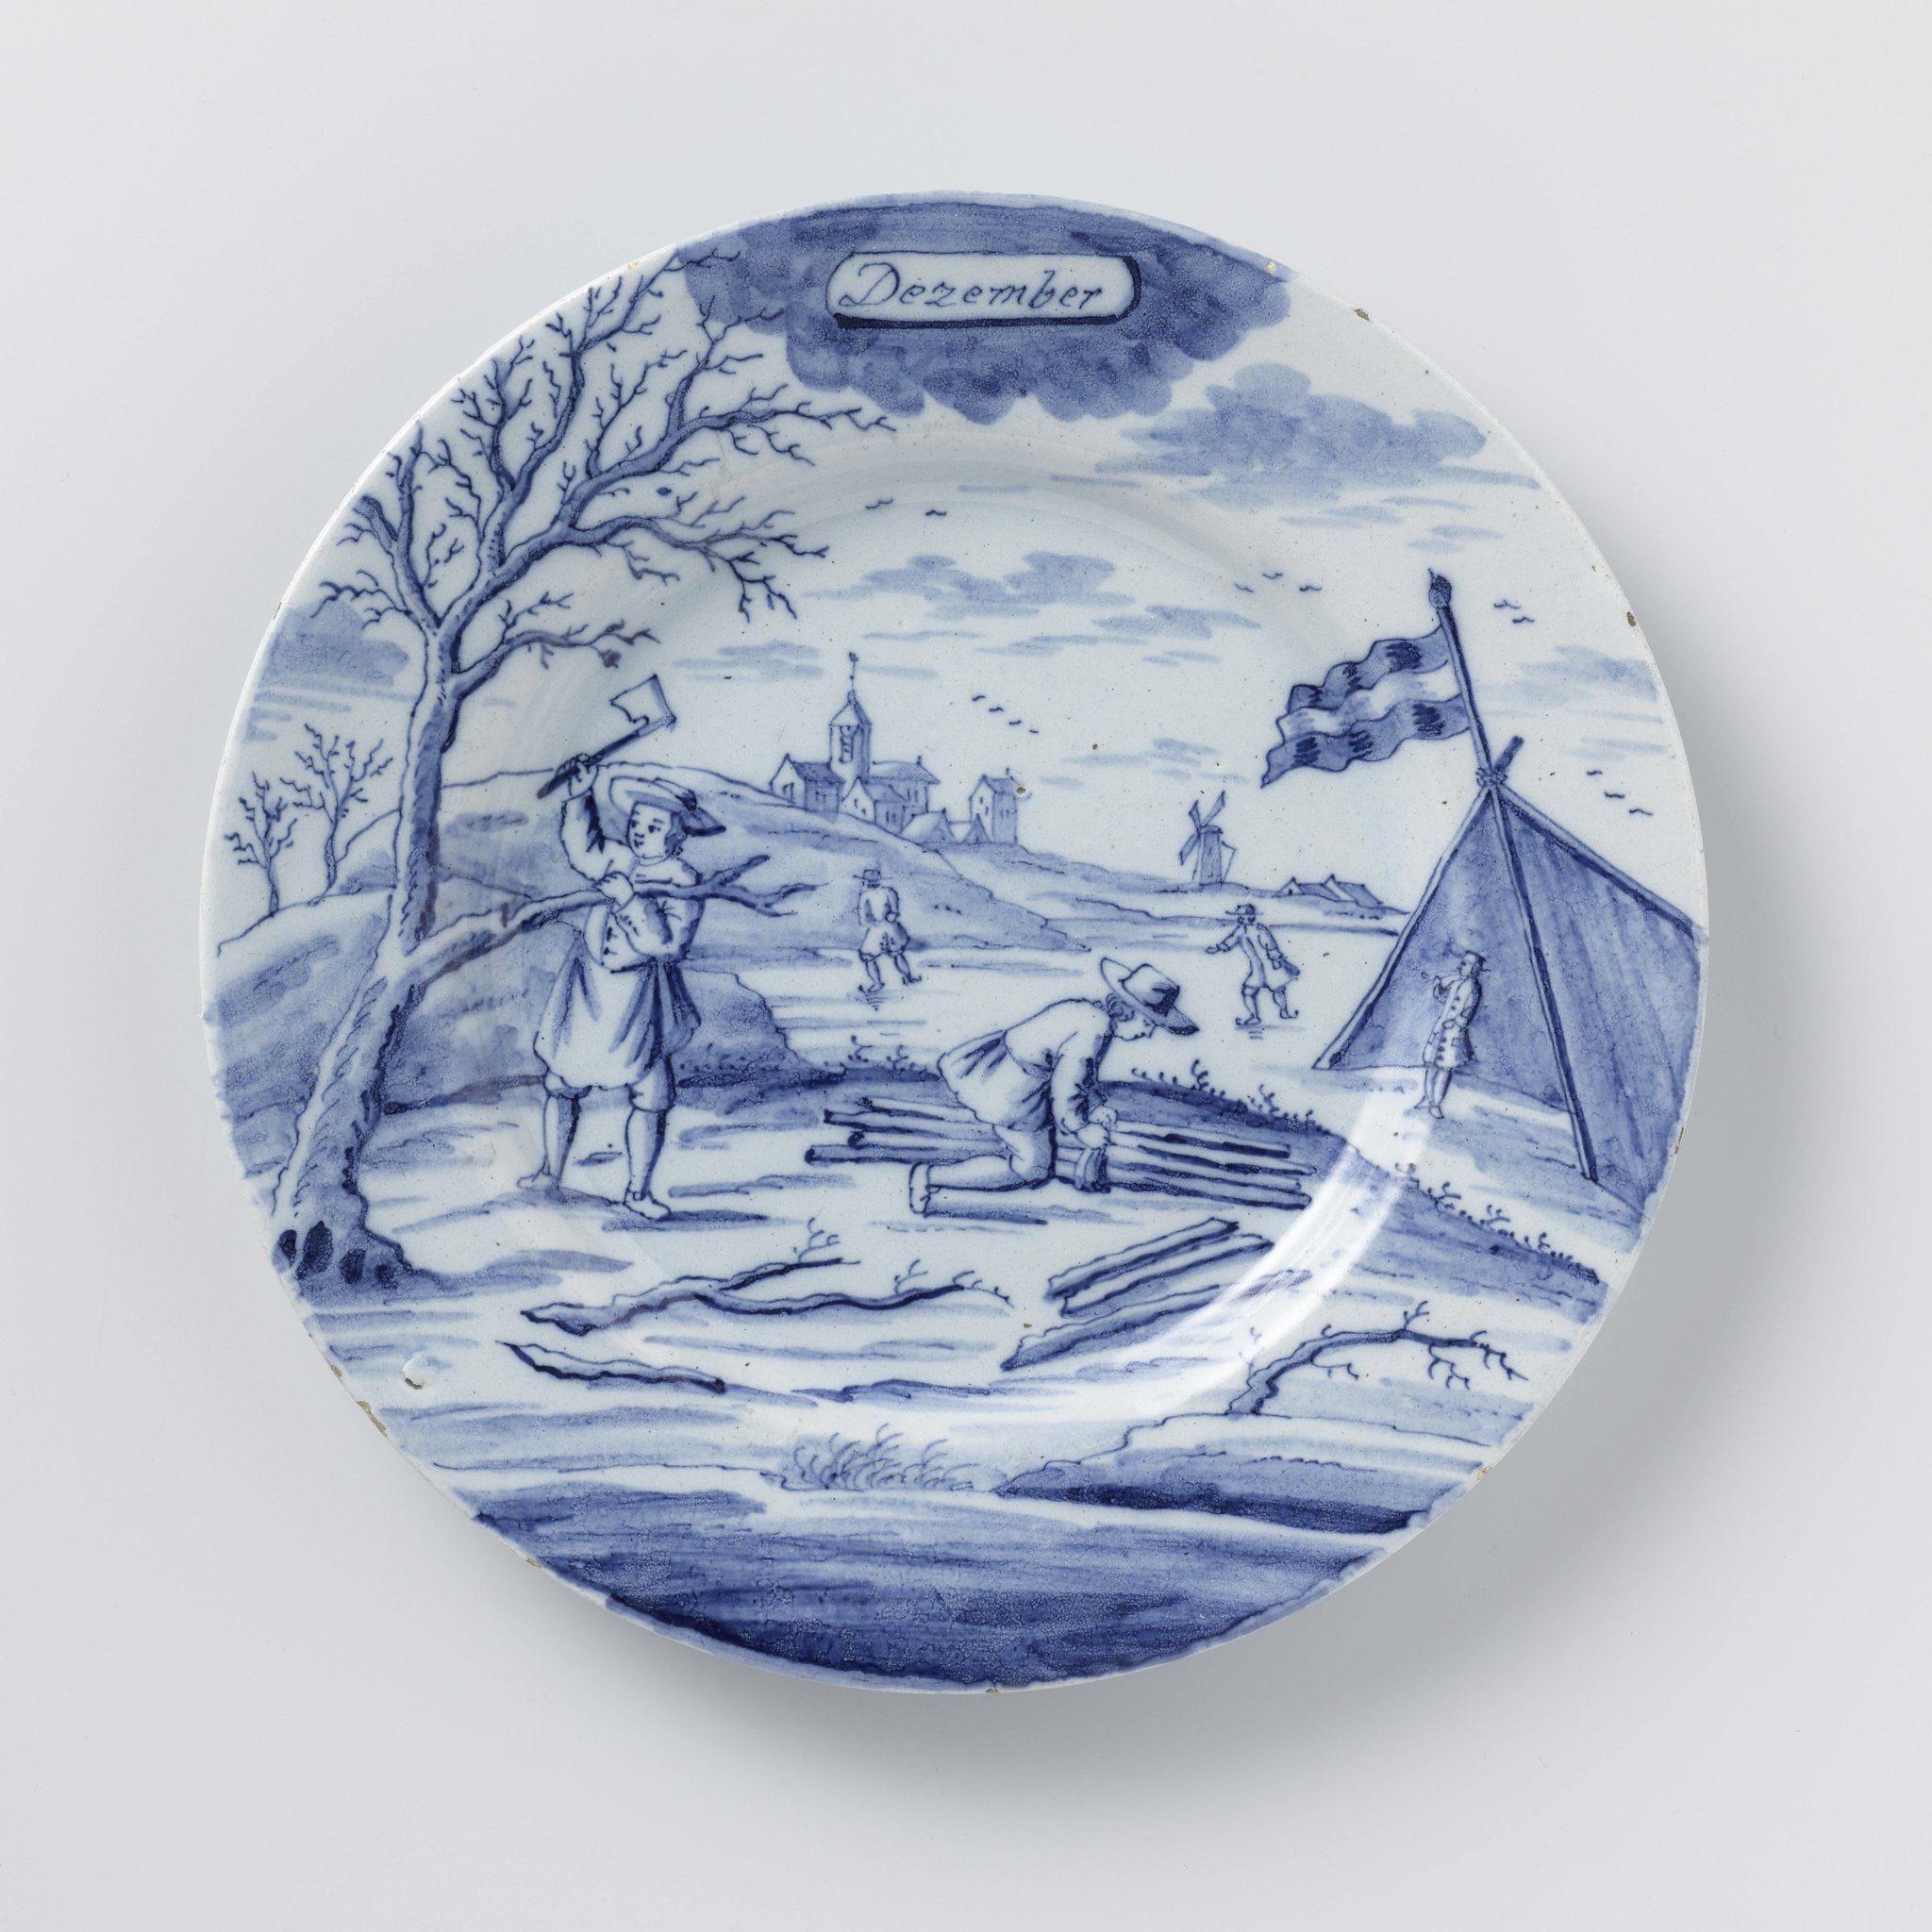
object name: plate dish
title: Bord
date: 1750-1780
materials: faience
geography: delft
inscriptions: mark: ‘figuratief teken bijltje’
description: Bord van faience, uit de serie de 12 maanden. Voorstellende de maand december. Afgebeeld zijn: de houthakkers, met de tekst: Dezember.